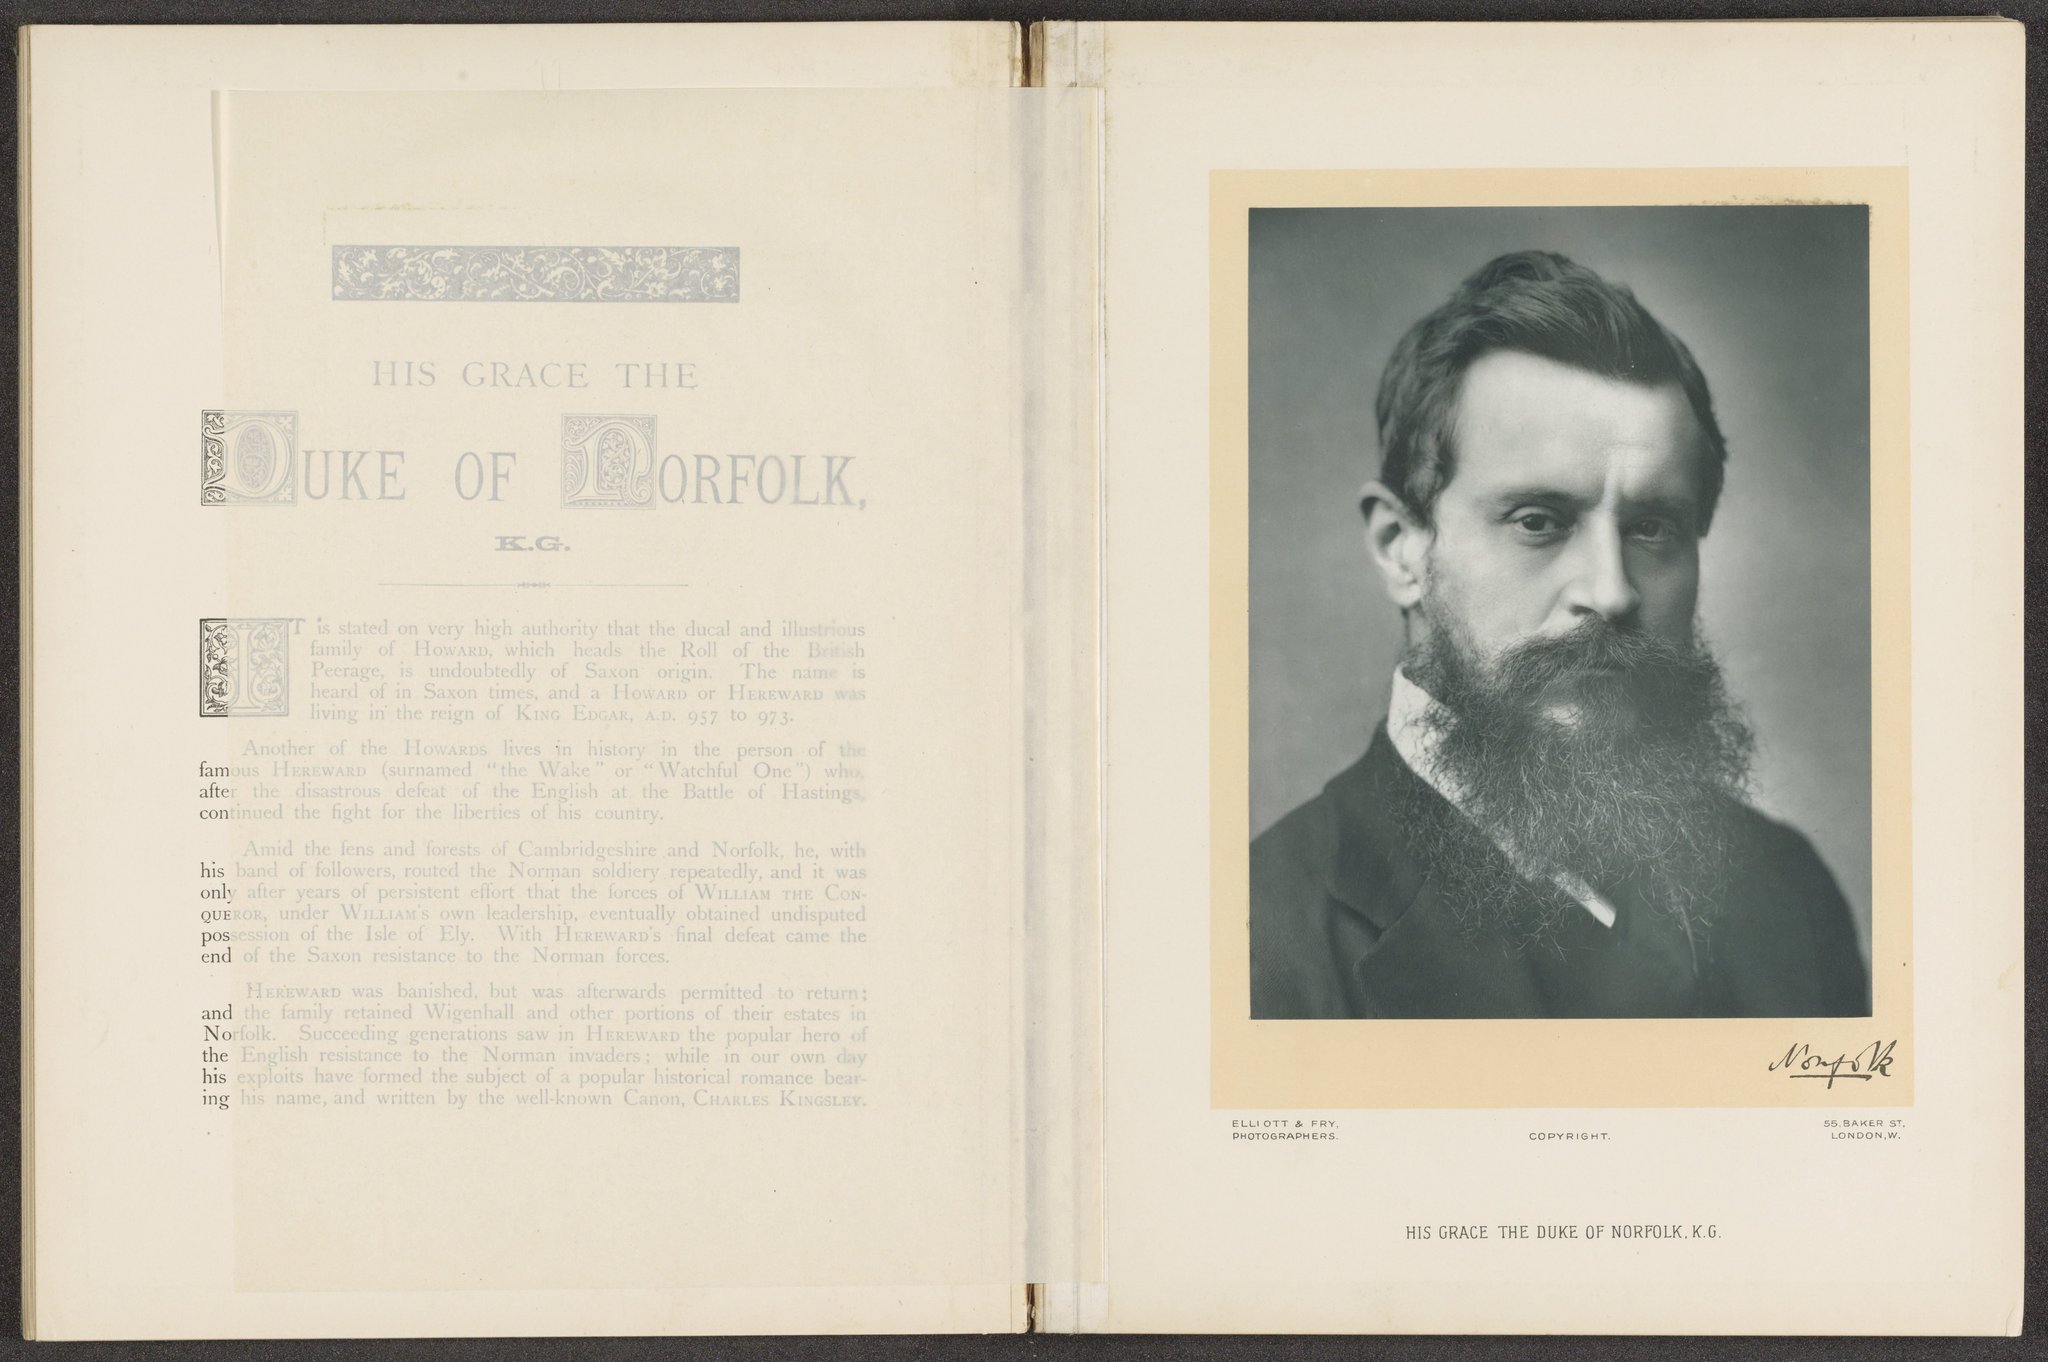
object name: photograph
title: His grace the duke of Norfolk, K.G.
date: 1893-1903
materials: paper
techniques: carbon print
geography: london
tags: politician, historical persons (portraits and scenes from the life) (+ (full) bust portrait)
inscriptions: annotation, inscription: ‘55, Baker St, London, W.’